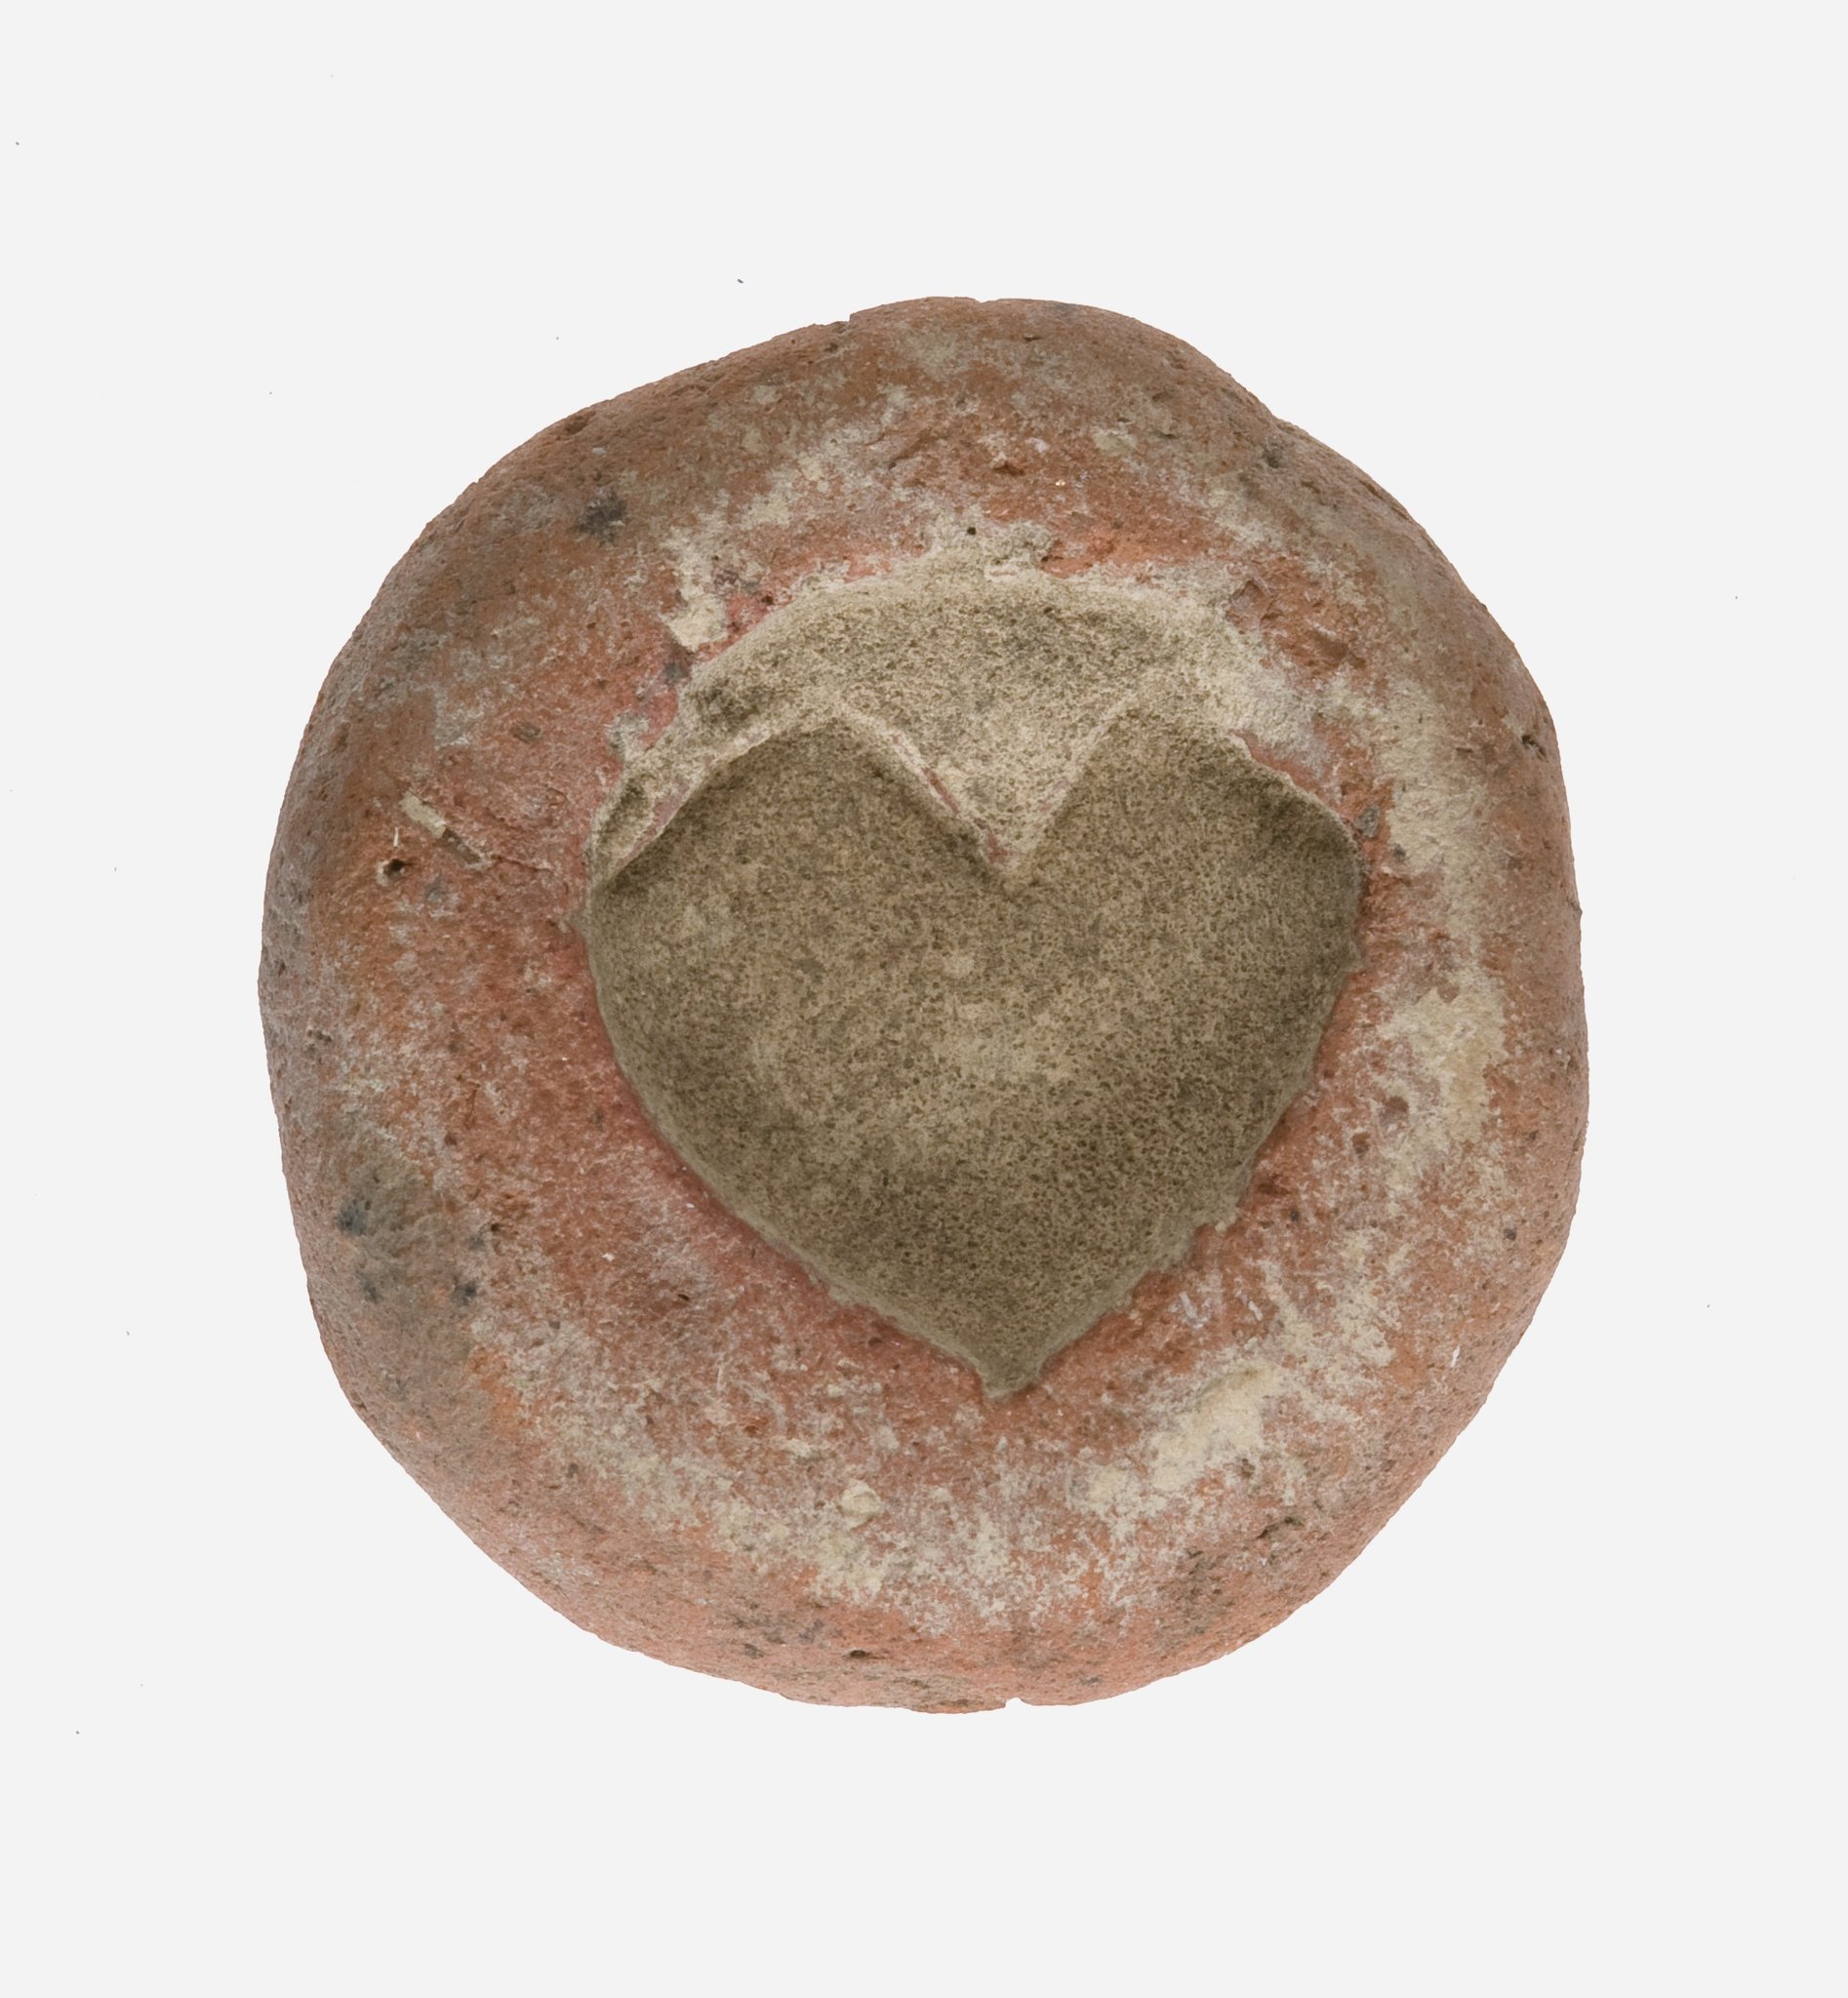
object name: mold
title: Persia Fruit Mold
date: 1390-1352 BCE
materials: pottery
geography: egypt